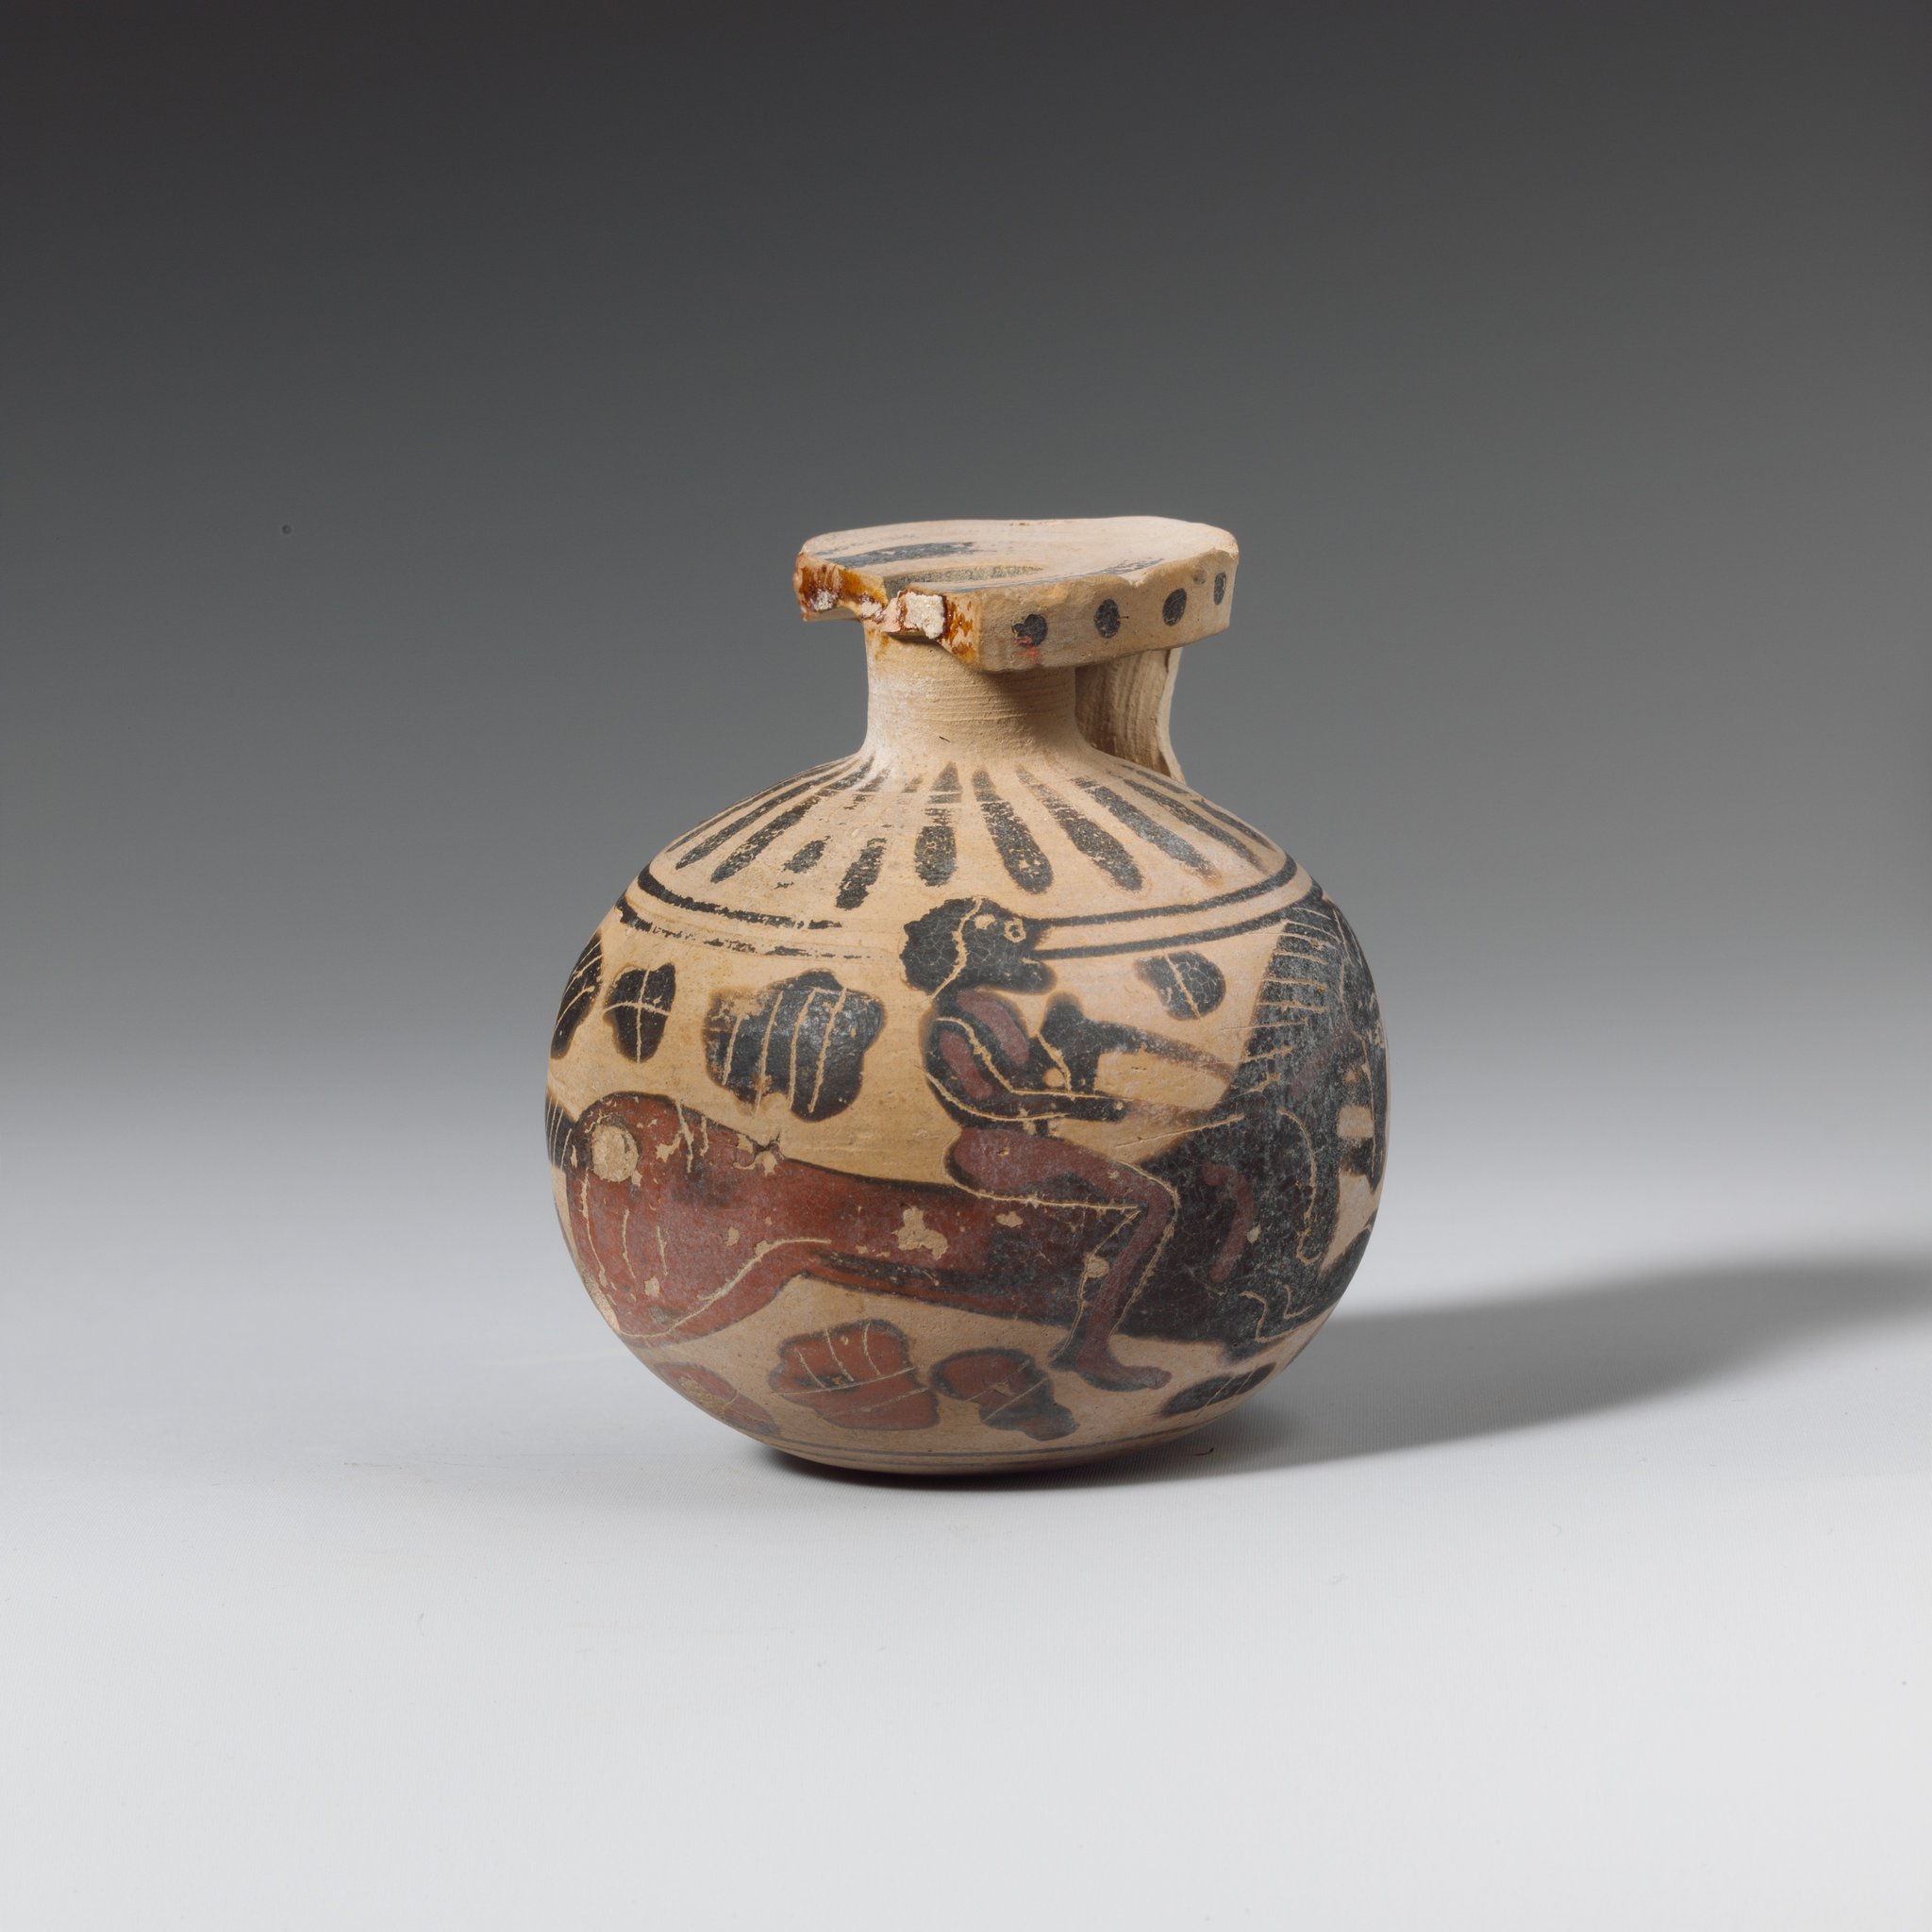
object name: aryballos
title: Terracotta aryballos (oil flask)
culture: greek, corinthian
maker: kaeppeli painter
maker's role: artist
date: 620-590 BCE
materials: terracotta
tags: men,horses